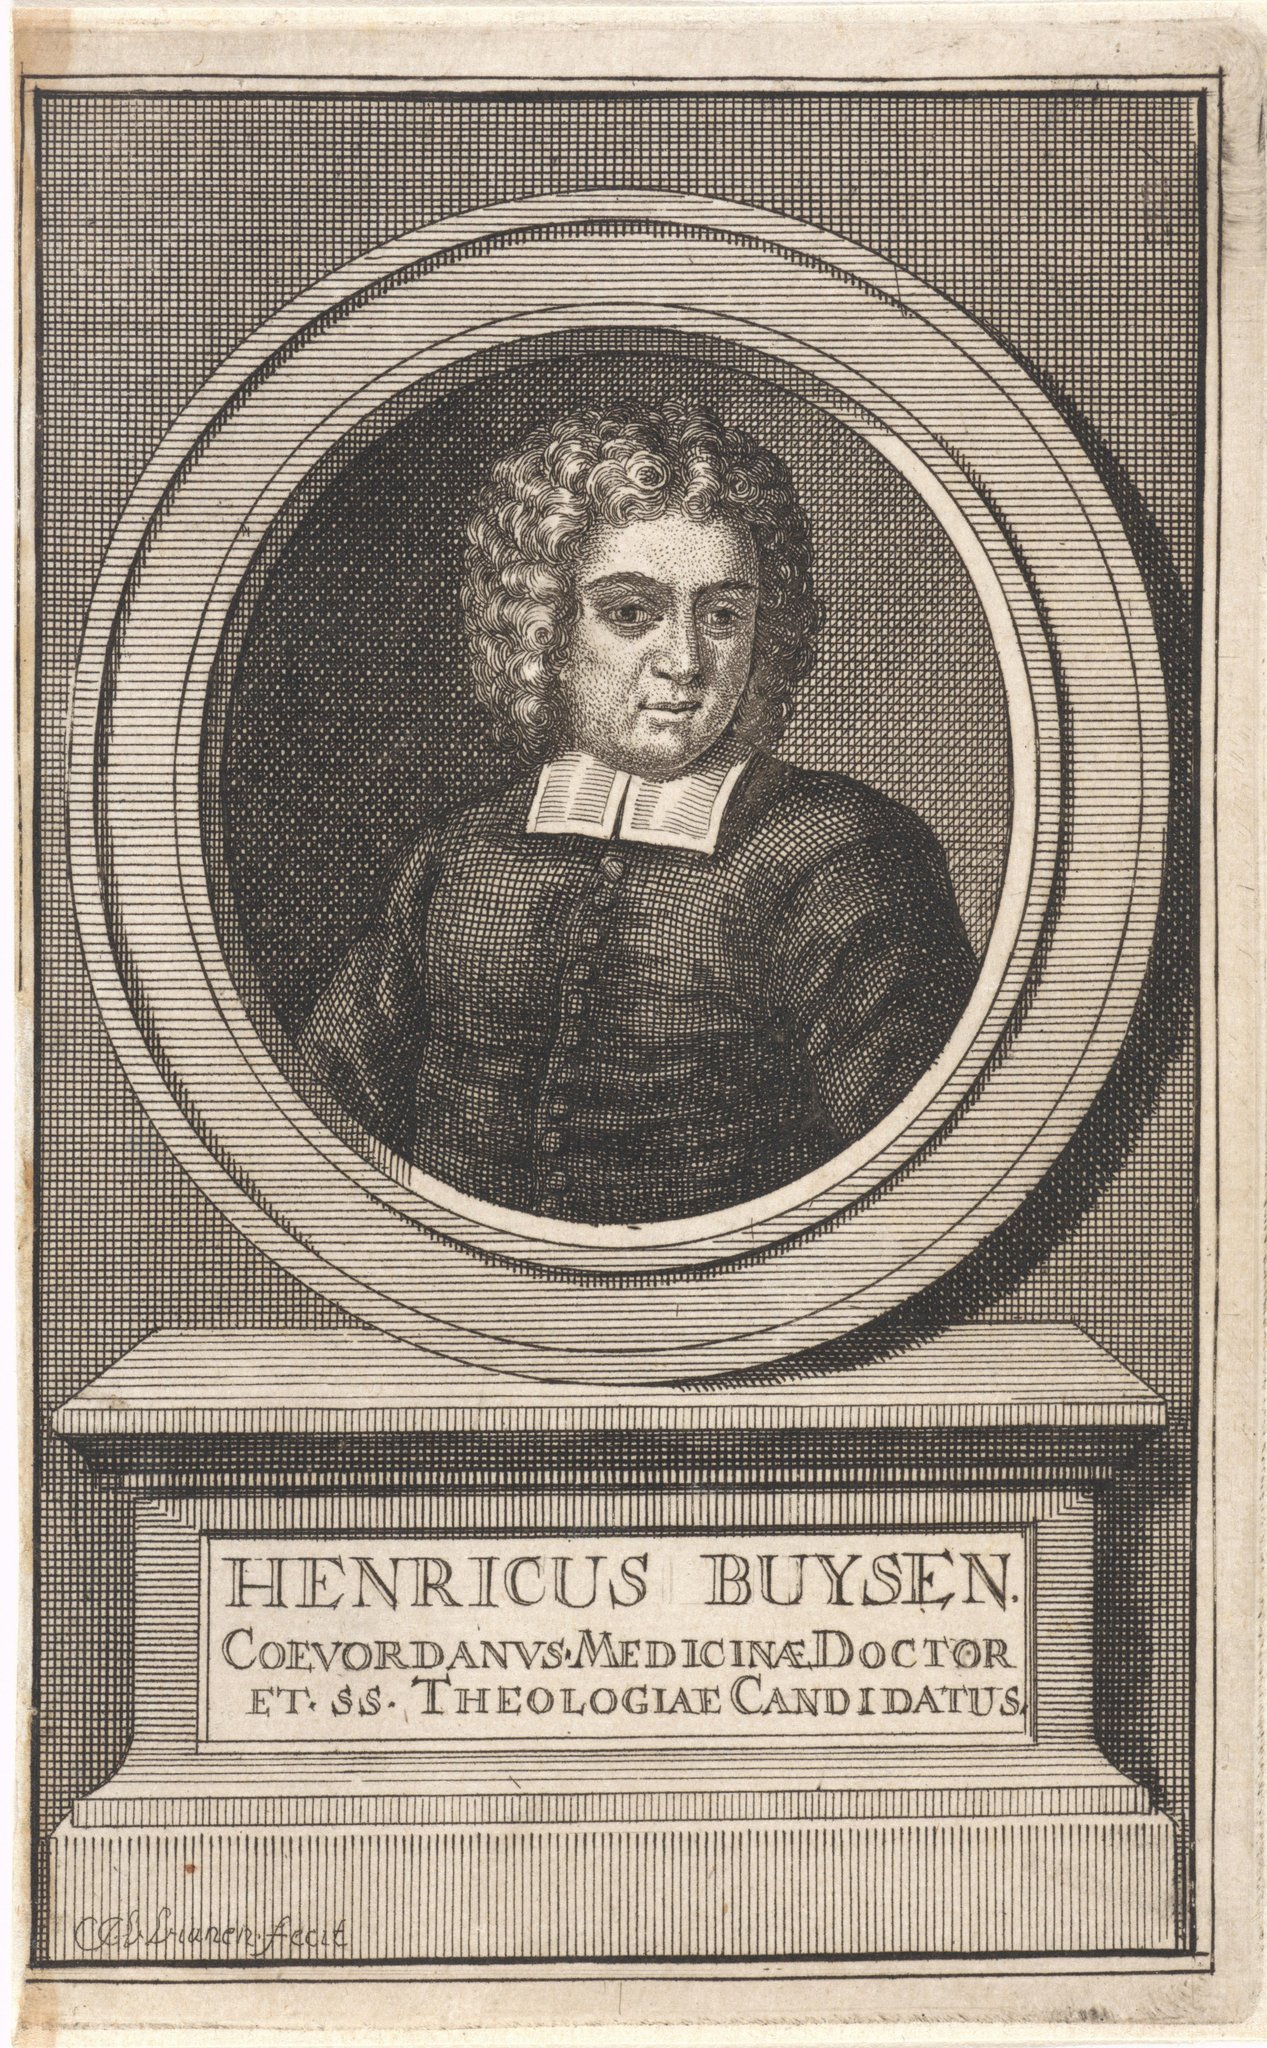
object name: print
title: Portret van Henricus Buysen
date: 1710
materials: paper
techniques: etching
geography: haarlem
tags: schrijver, medicus, henricus buysen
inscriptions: collector's mark: Lugt 2228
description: Prent ook gebruikt als boekillustratie in: Buysen, Henricus. Practyk der medicine, synde een korte beschryvinge der meest voorkomende siektens. Haarlem: Wilhelmus van Kessel, 1710.